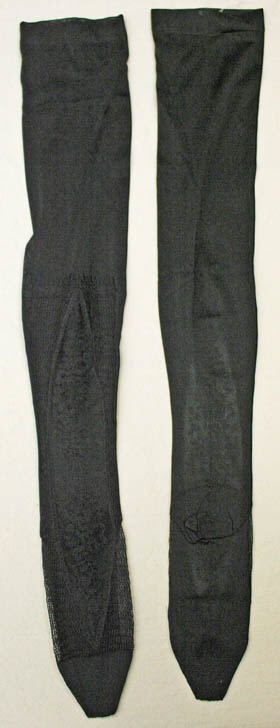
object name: stocking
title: Stockings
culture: french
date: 1801-1900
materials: silk